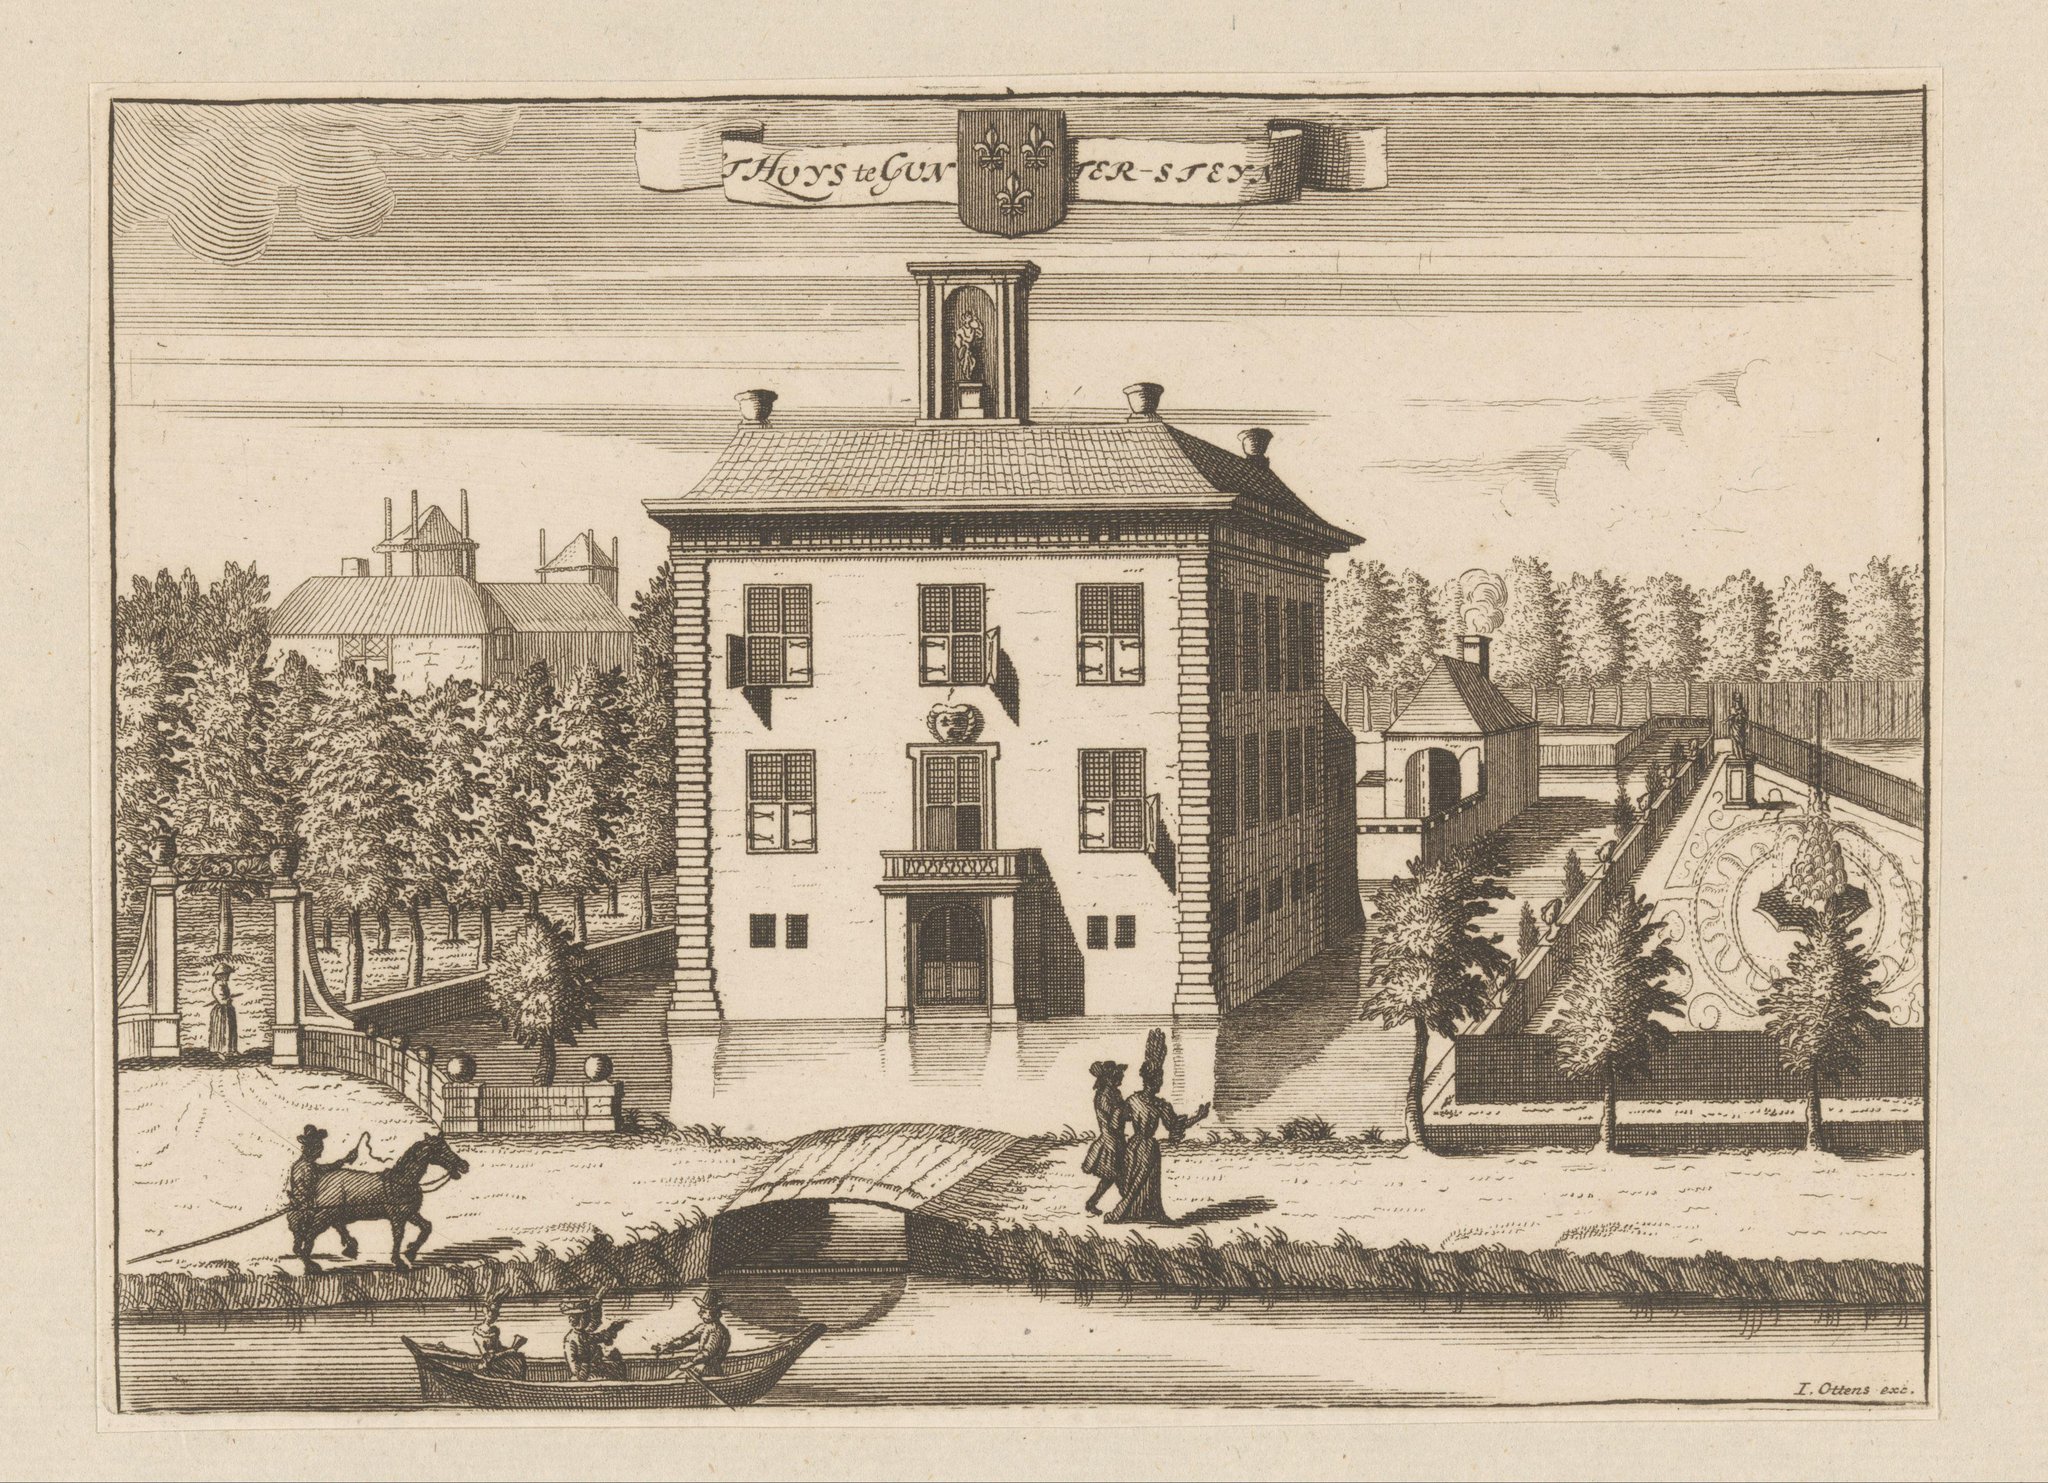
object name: print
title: 't Huys te Gunter-steyn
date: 1710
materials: paper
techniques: engraving, etching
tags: castle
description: Prent uit: De Ridder-matige Huysen en Gesichten in de Provincie van Utrecht. Amsterdam: Joachim Ottens, [ca. 1710].